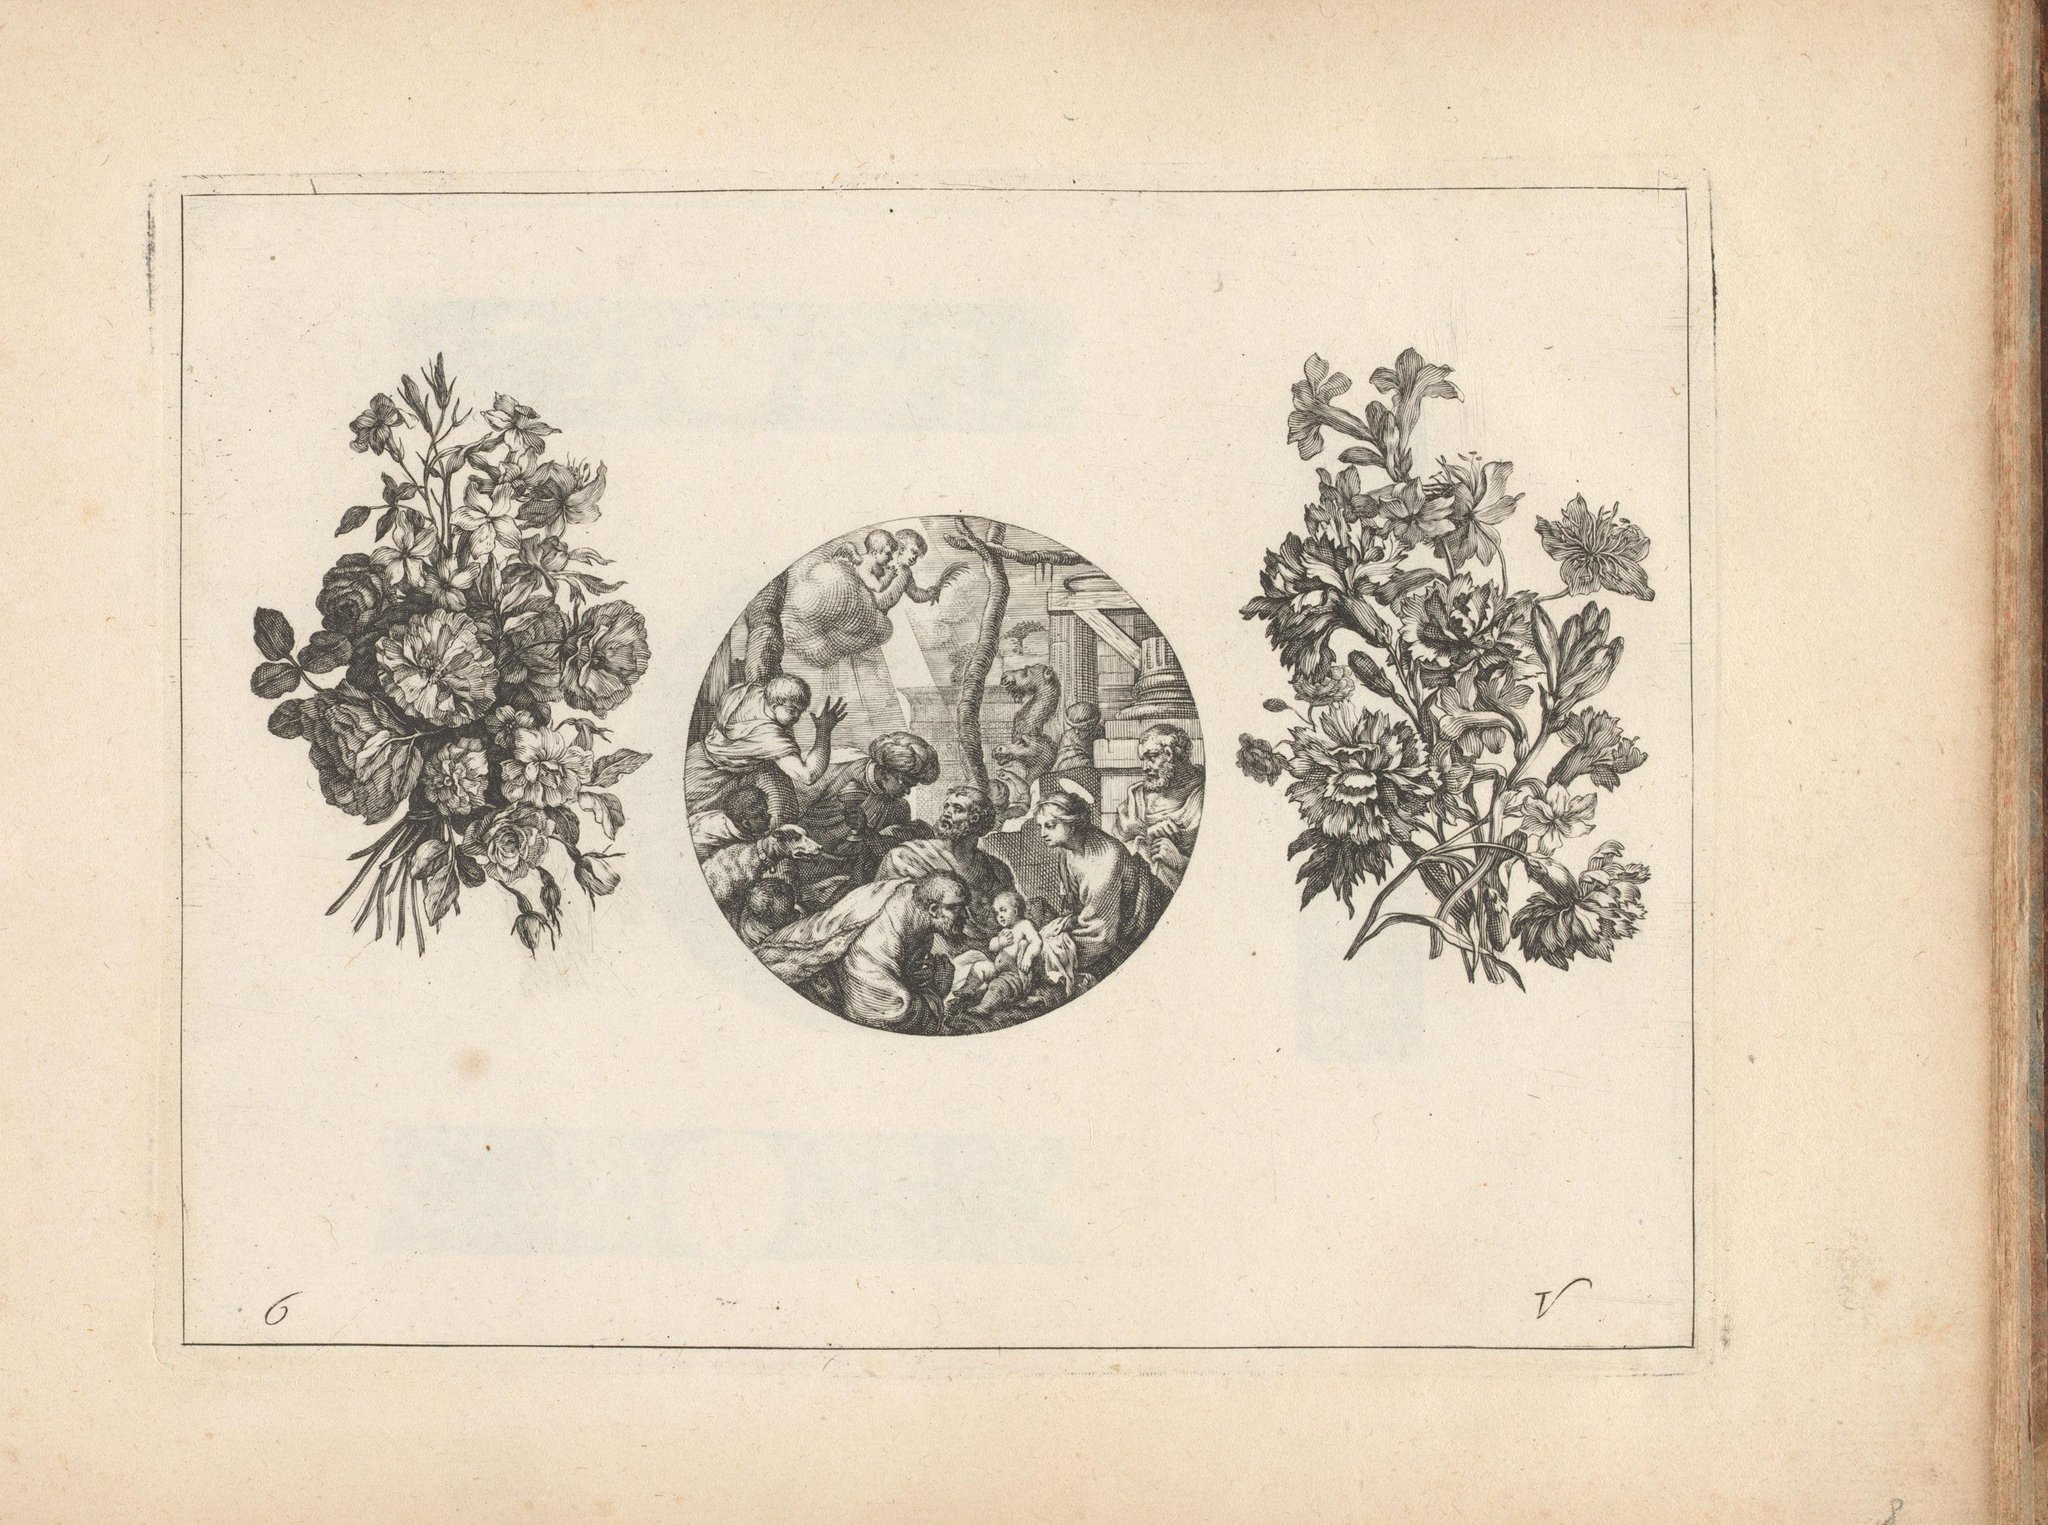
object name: album leaf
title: Edelsmidsontwerpen voor horlogekasten: deksels en zijkanten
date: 1650-1676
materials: paper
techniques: engraving, etching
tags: adoration of the kings: the wise men present their gifts to the christ-child (gold, frankincense and myrrh)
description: Zowel links als rechts van de horlogekast een boeket. Deze prent maakt deel uit van een album.